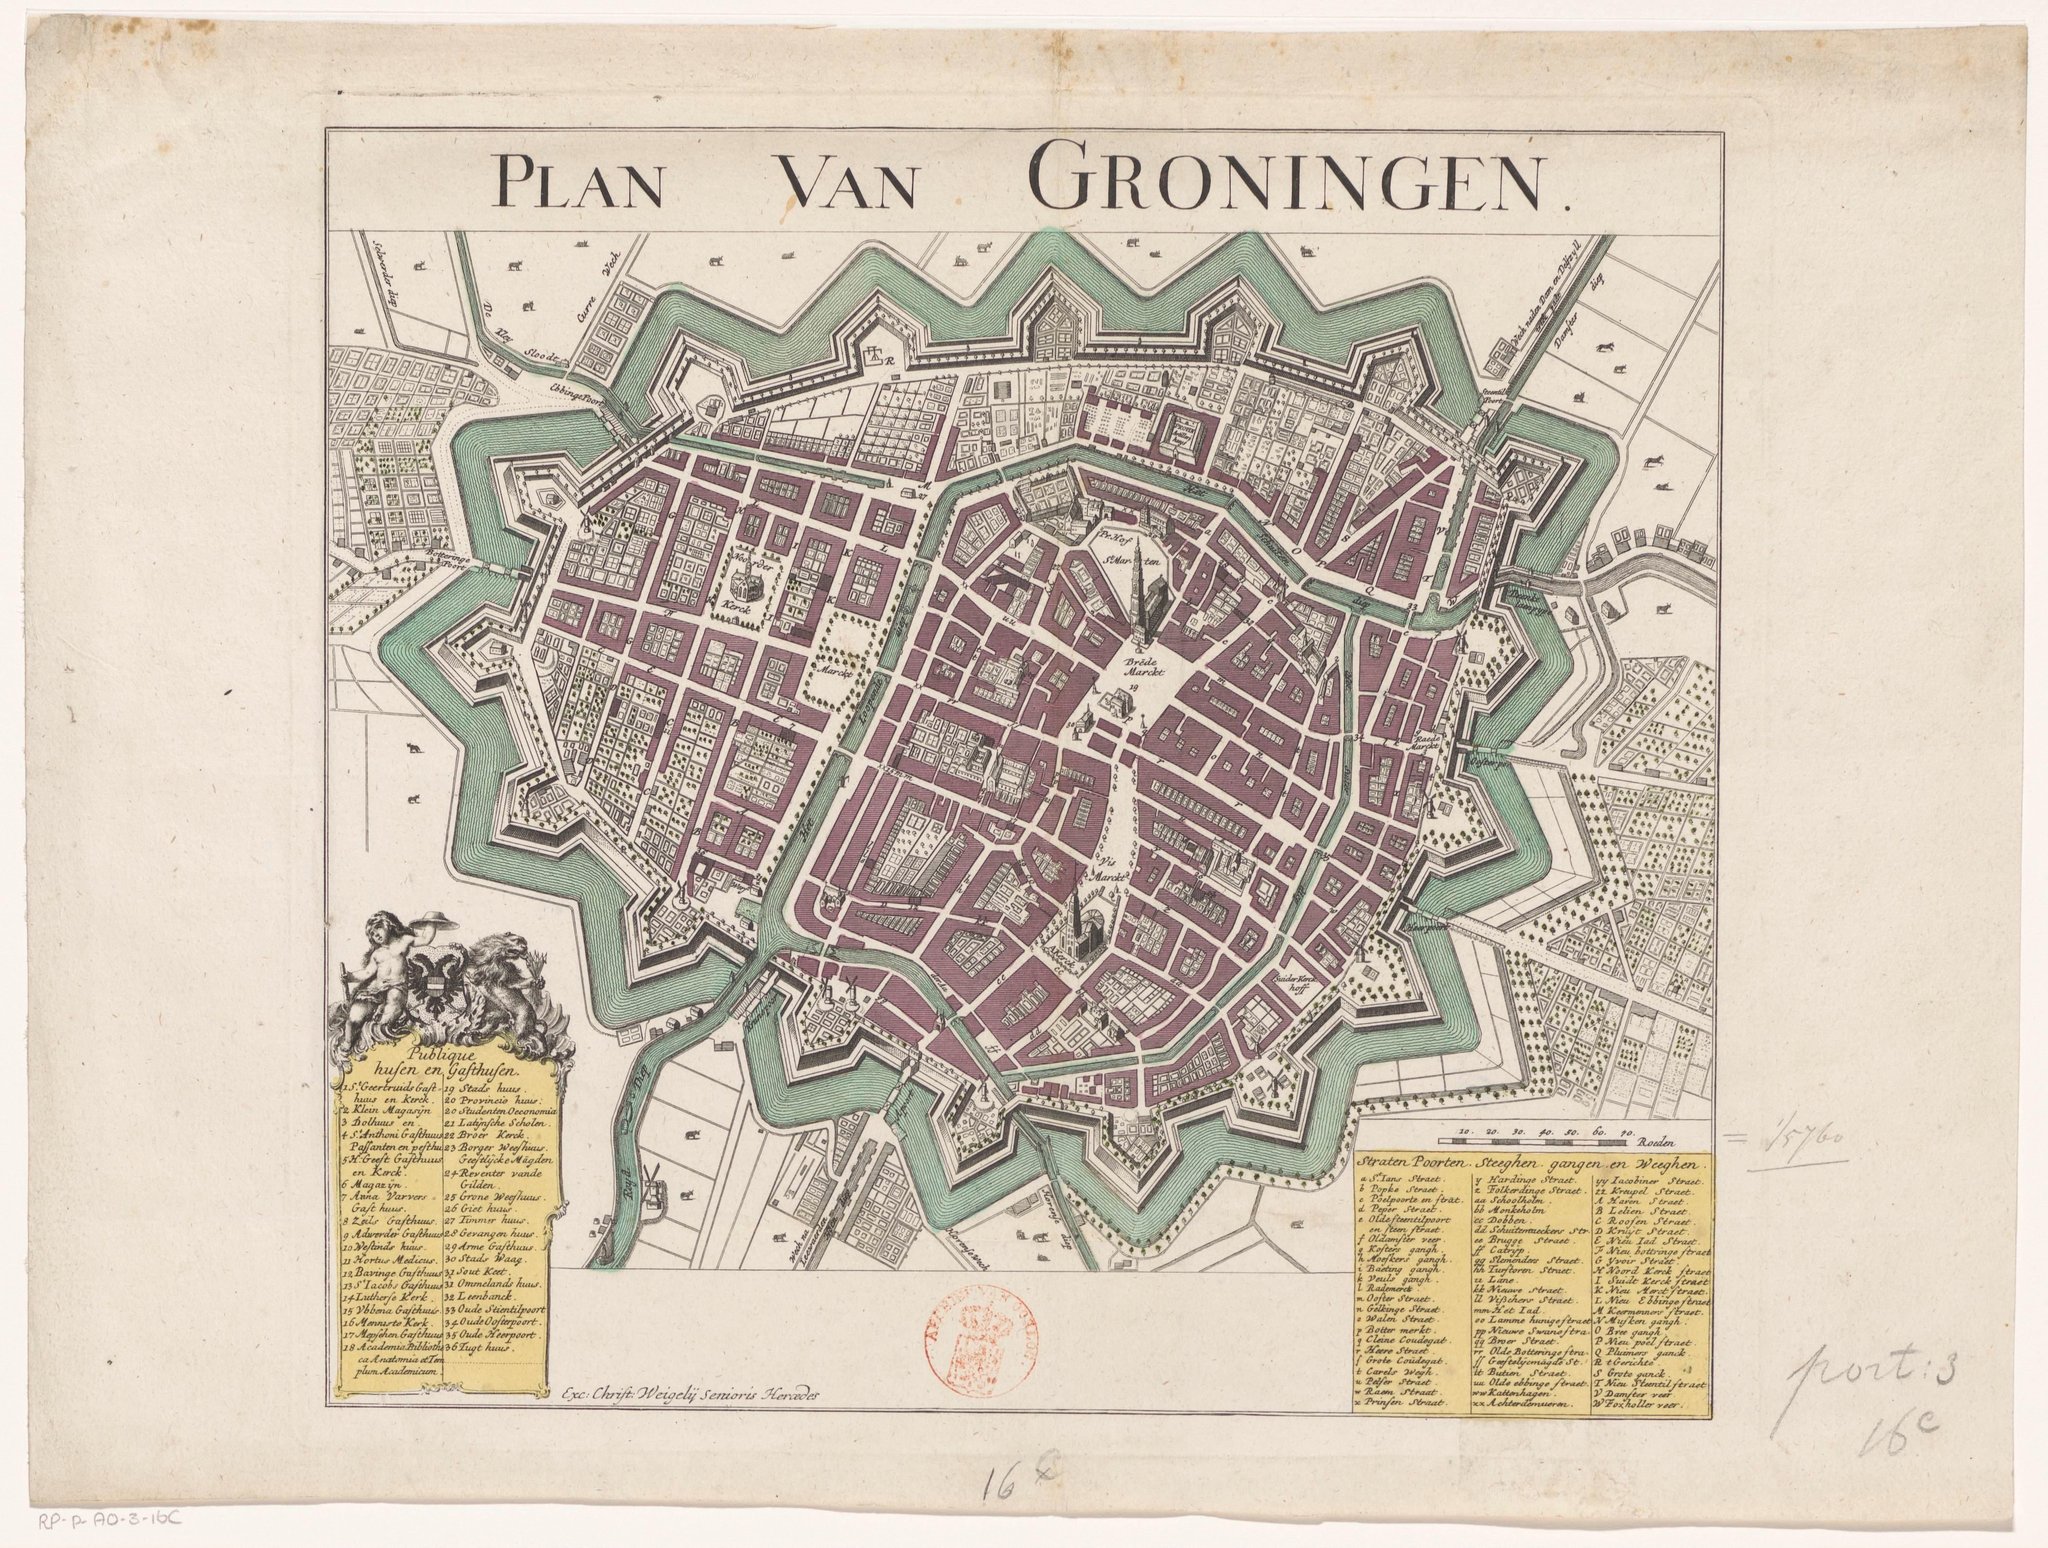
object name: area plan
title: Plattegrond van de stad Groningen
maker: Anonymous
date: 1725-1790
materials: paper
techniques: engraving, etching, hand coloring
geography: nuremberg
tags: coat of arms (as symbol of the state, etc.), maps of cities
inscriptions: collector's mark: Lugt 2228, collector's mark: 19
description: Plattegrond in vogelvluchtperspectief. Linksonder cartouche met legenda, het wapen van de stad Groningen een jongen met de vrijheidshoed en de Nederlandse Leeuw met pijlenbundel. Rechtsonder nog een legenda en een schaalstok: Roeden.